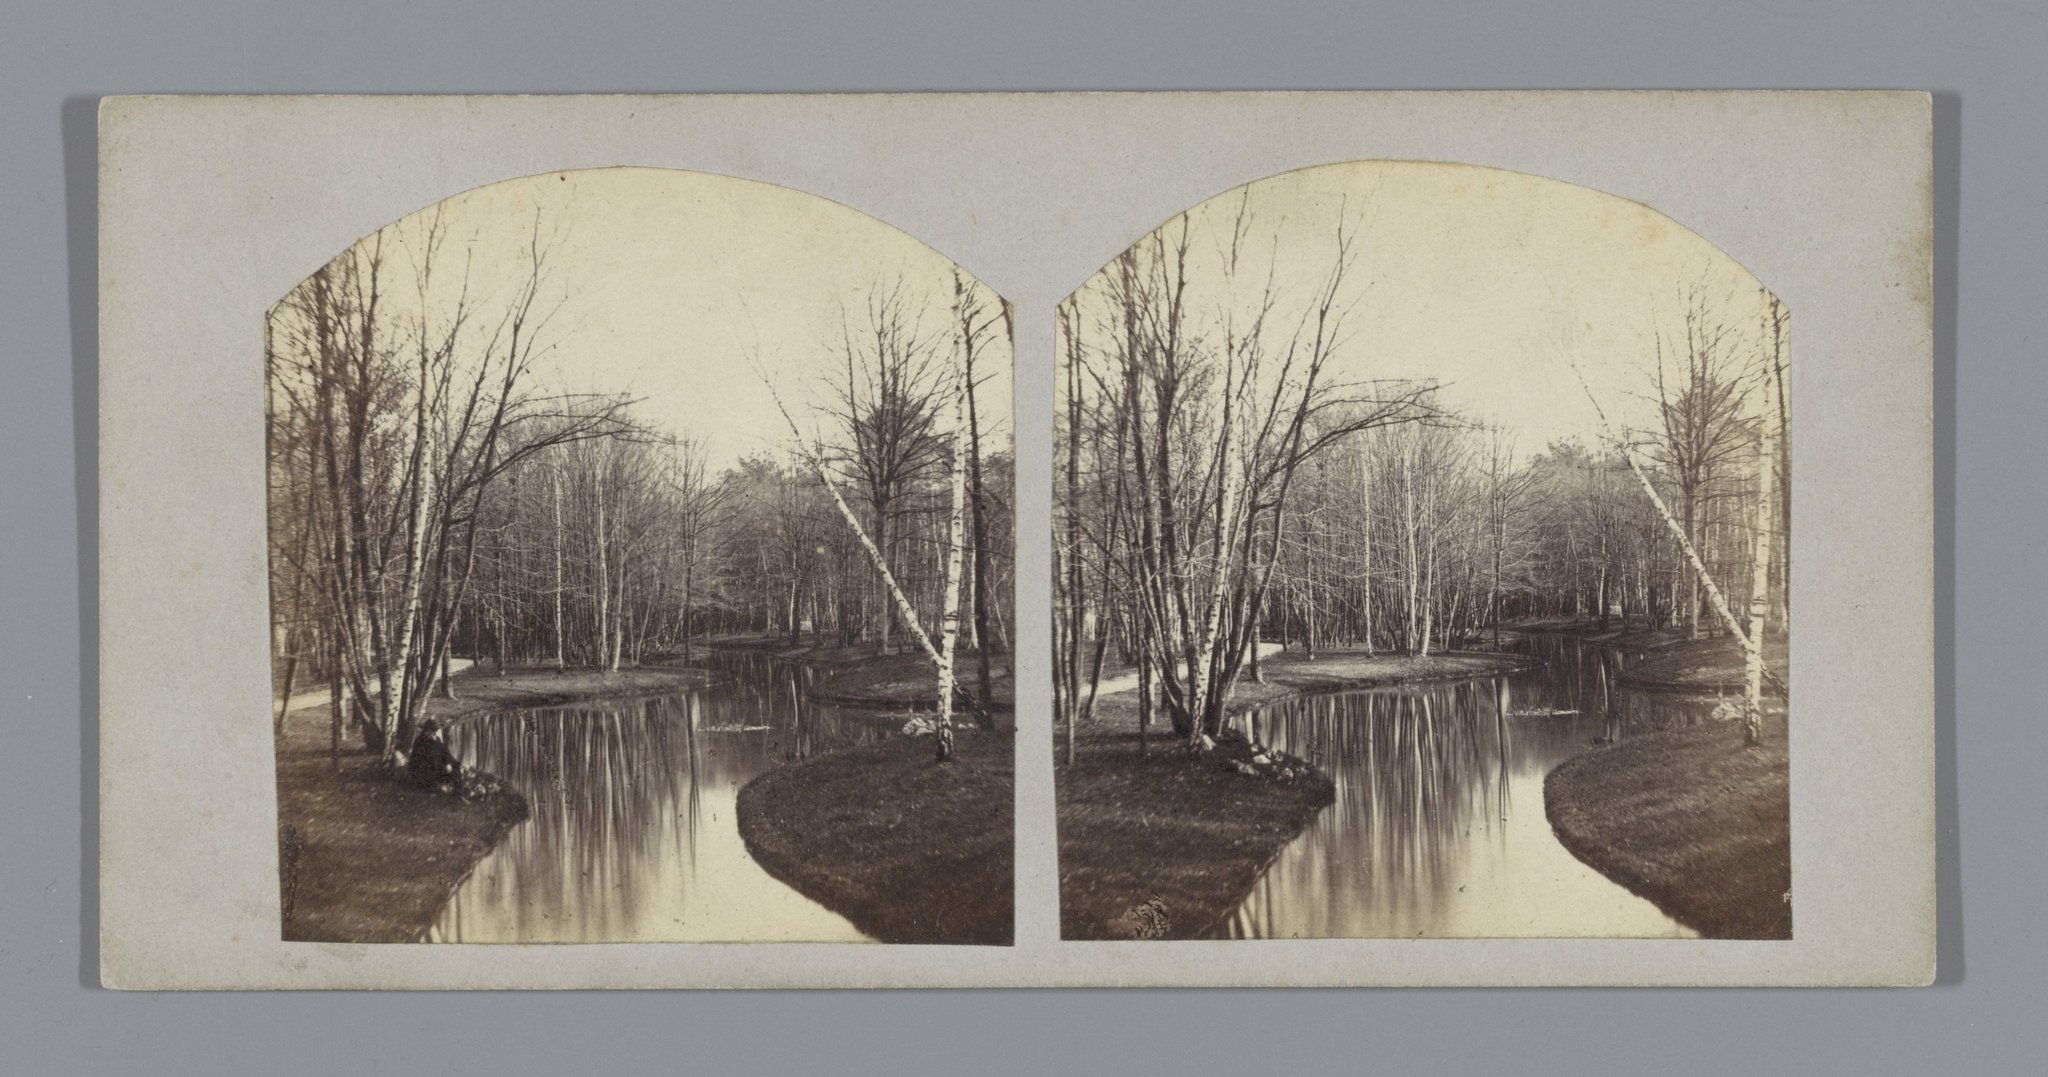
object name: stereograph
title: Bois de Boulogne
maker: Anonymous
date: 1860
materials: cardboard, photographic support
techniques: albumen print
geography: paris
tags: public gardens, park